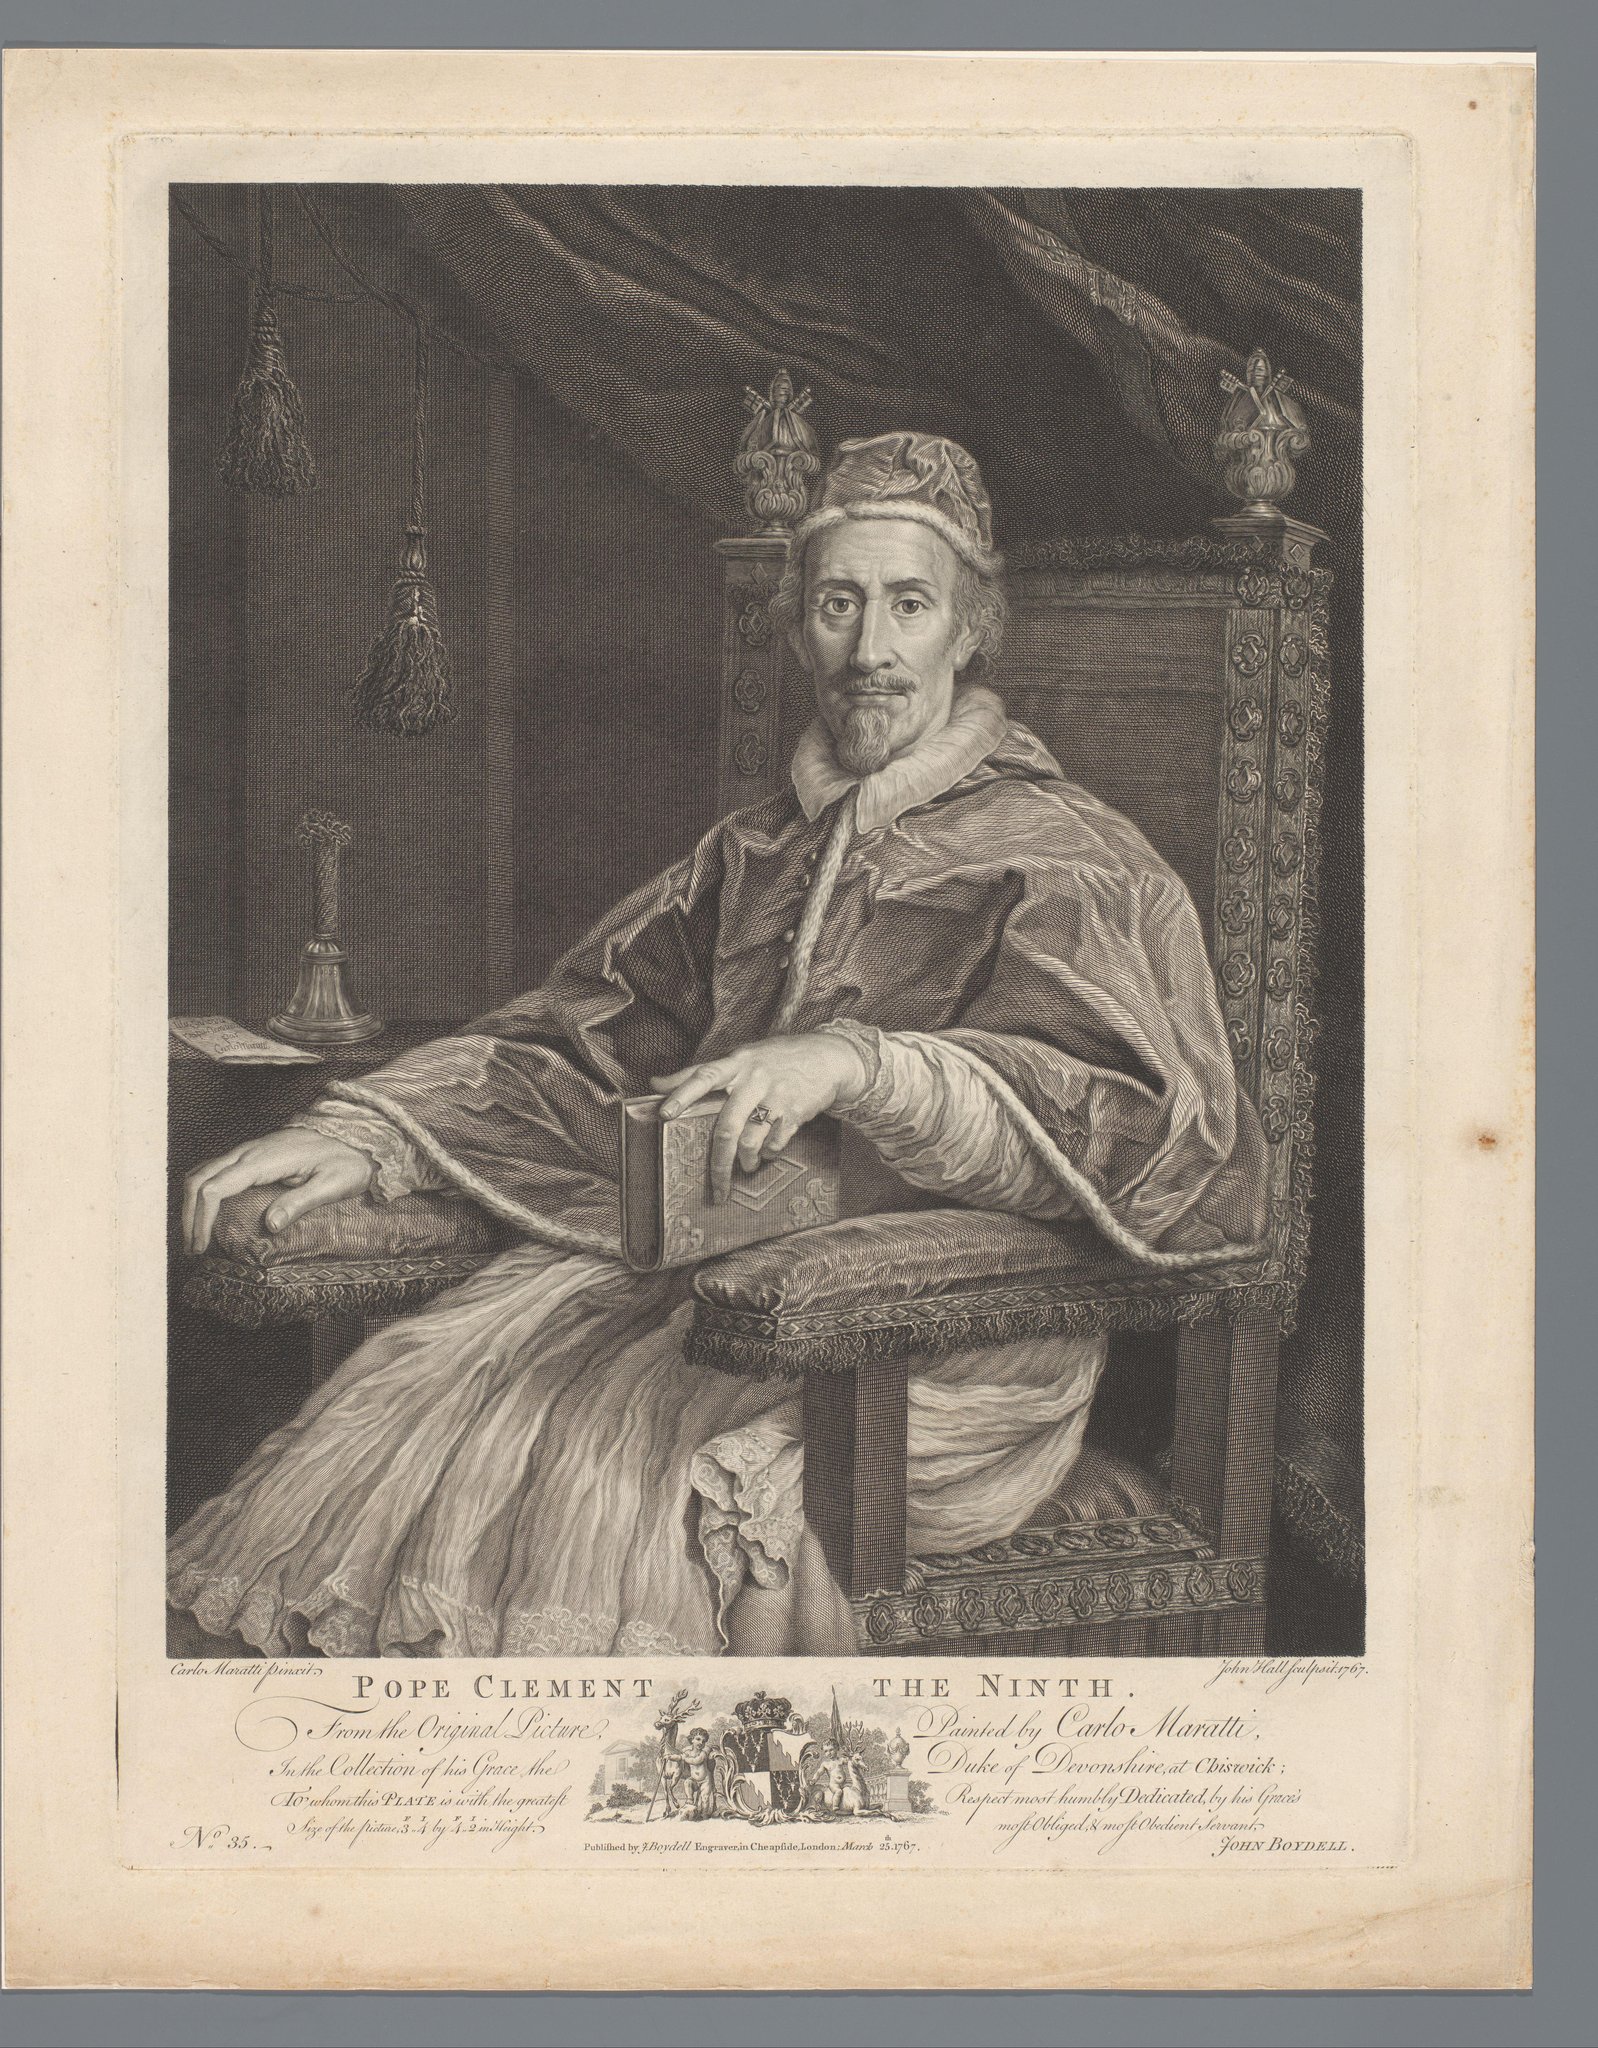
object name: print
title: The Most Capital Paintings in England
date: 1767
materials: paper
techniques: etching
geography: london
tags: clemens ix, historical persons, pope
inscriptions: date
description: Prent hoort vermoedelijk bij de serie The Most Capital Paintings in England, tussen 1763 en 1786 uitgegeven door John Boydell.